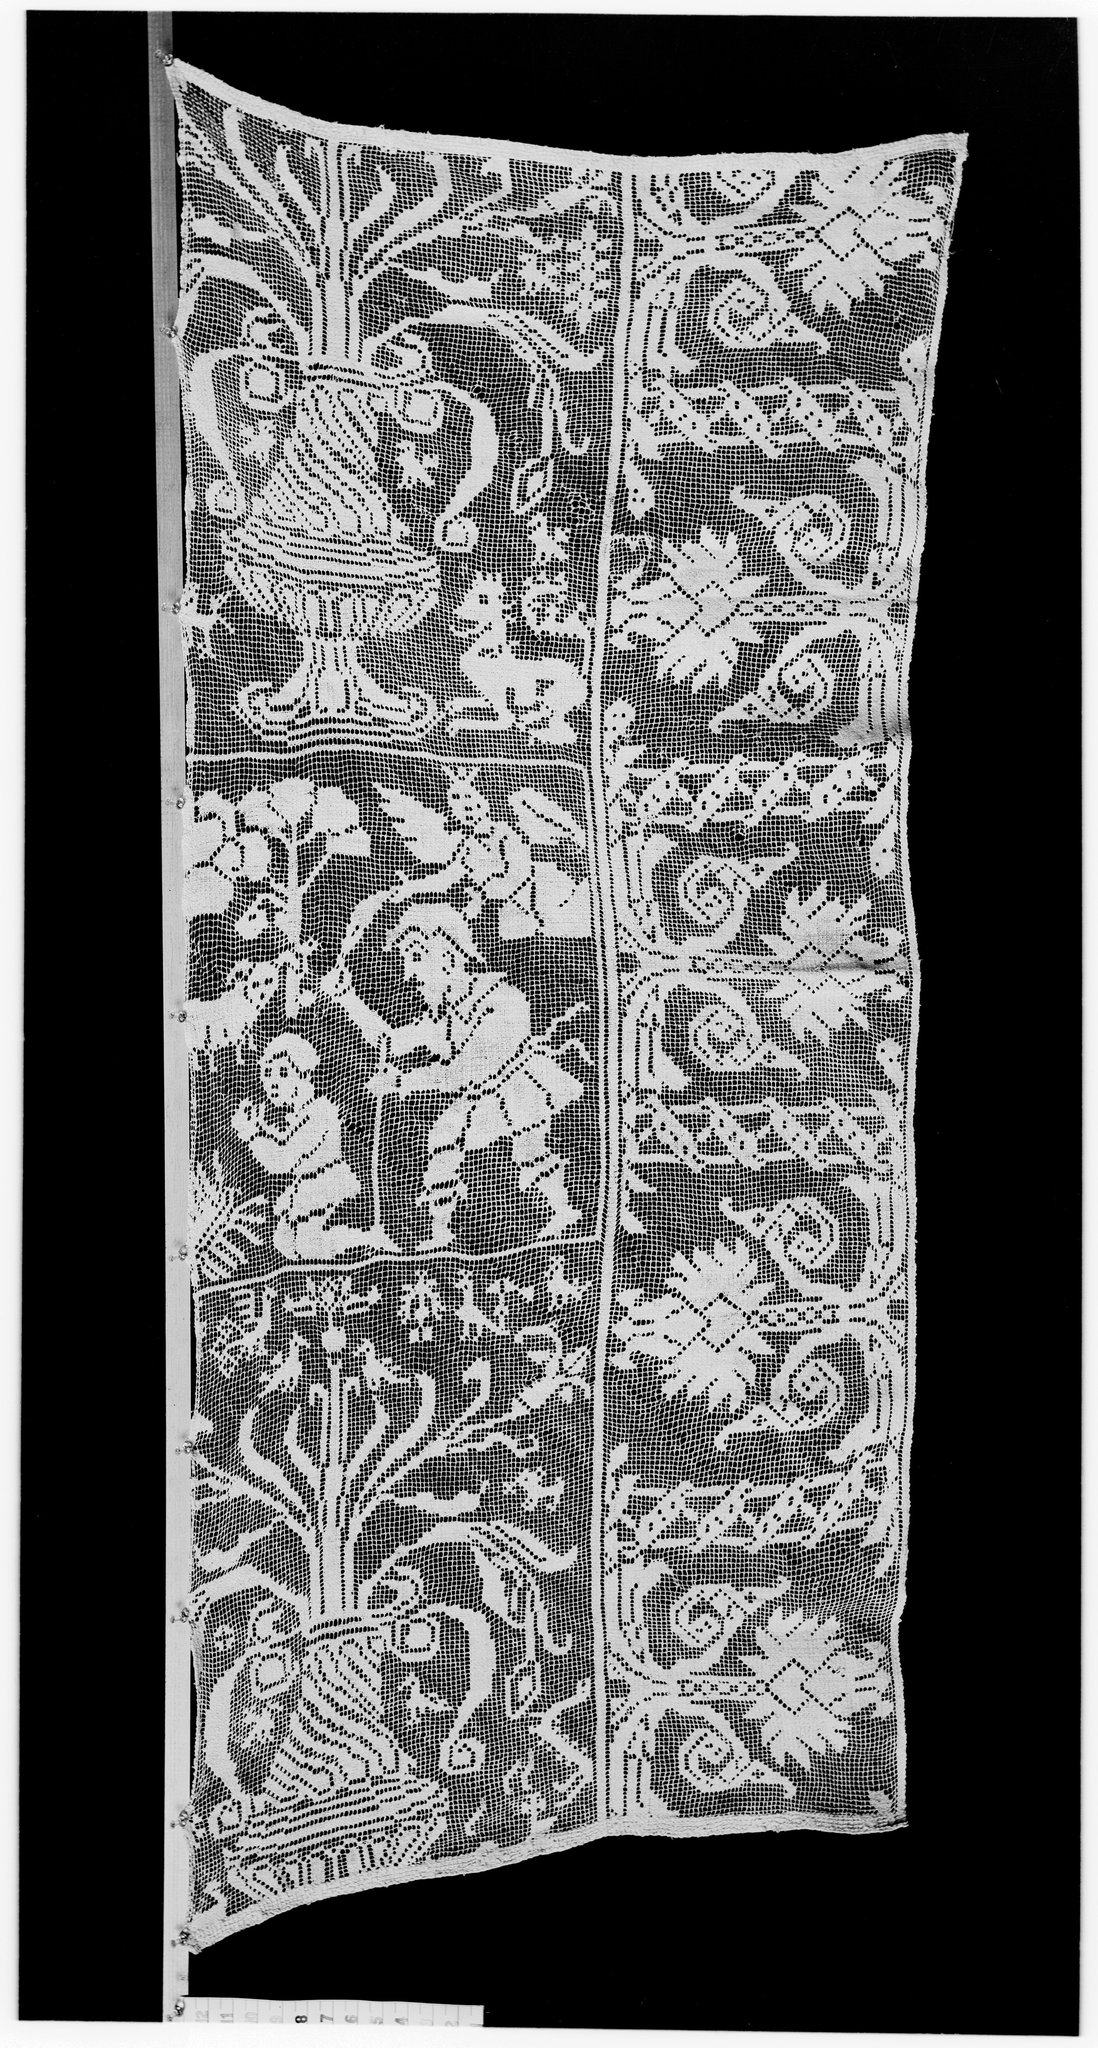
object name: hanging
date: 1501-1533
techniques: embroidery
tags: animals,men